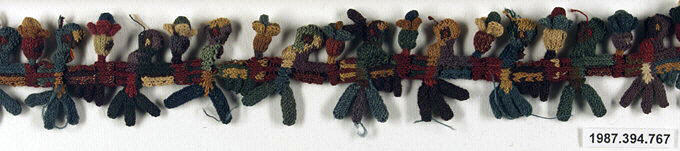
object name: border fragment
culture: nasca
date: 200-101 BCE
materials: animal fiber, cotton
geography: peru